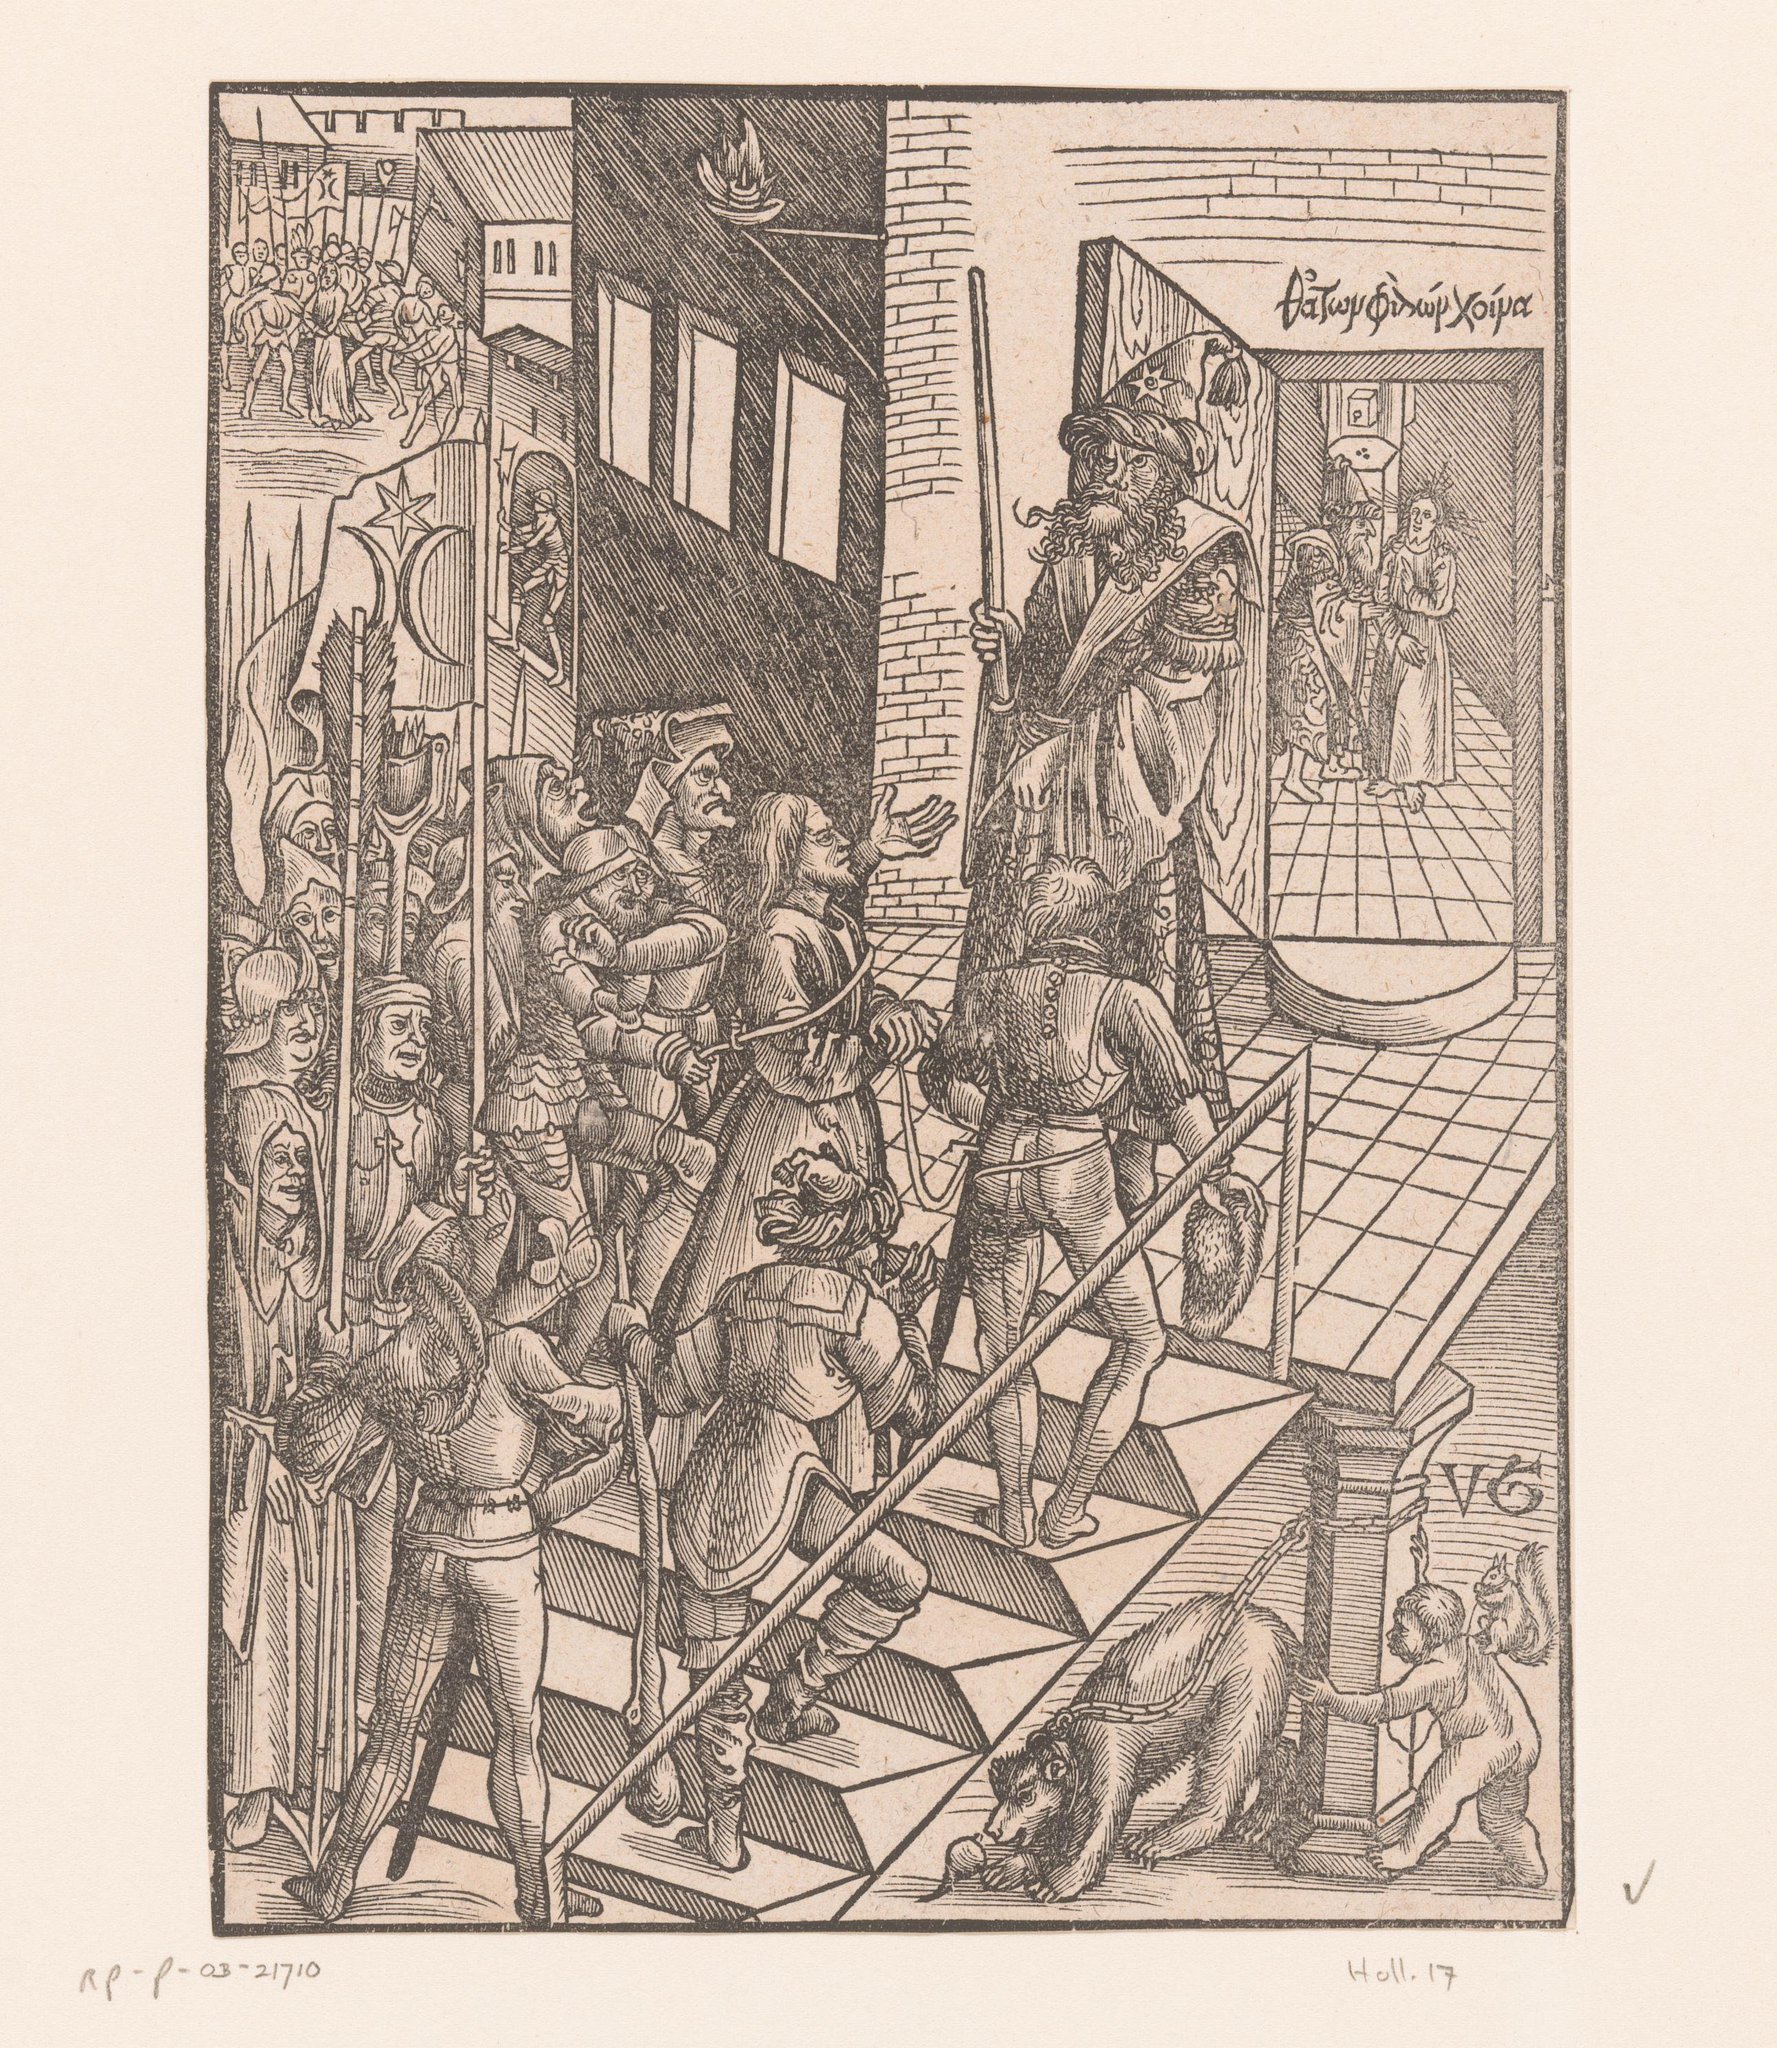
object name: print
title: Christus voor Pilatus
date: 1506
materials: paper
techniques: woodcut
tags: christ before pontius pilate (matthew 27:11-26; mark 15:2-15; luke 23:2-7, 23:13-25; john 18:28 - 19:16)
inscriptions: collector's mark: Lugt 240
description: Afkomstig uit: Der Text des Passions oder Lidens Christi (...). Straatsburg: N. Ringmann, 1506.